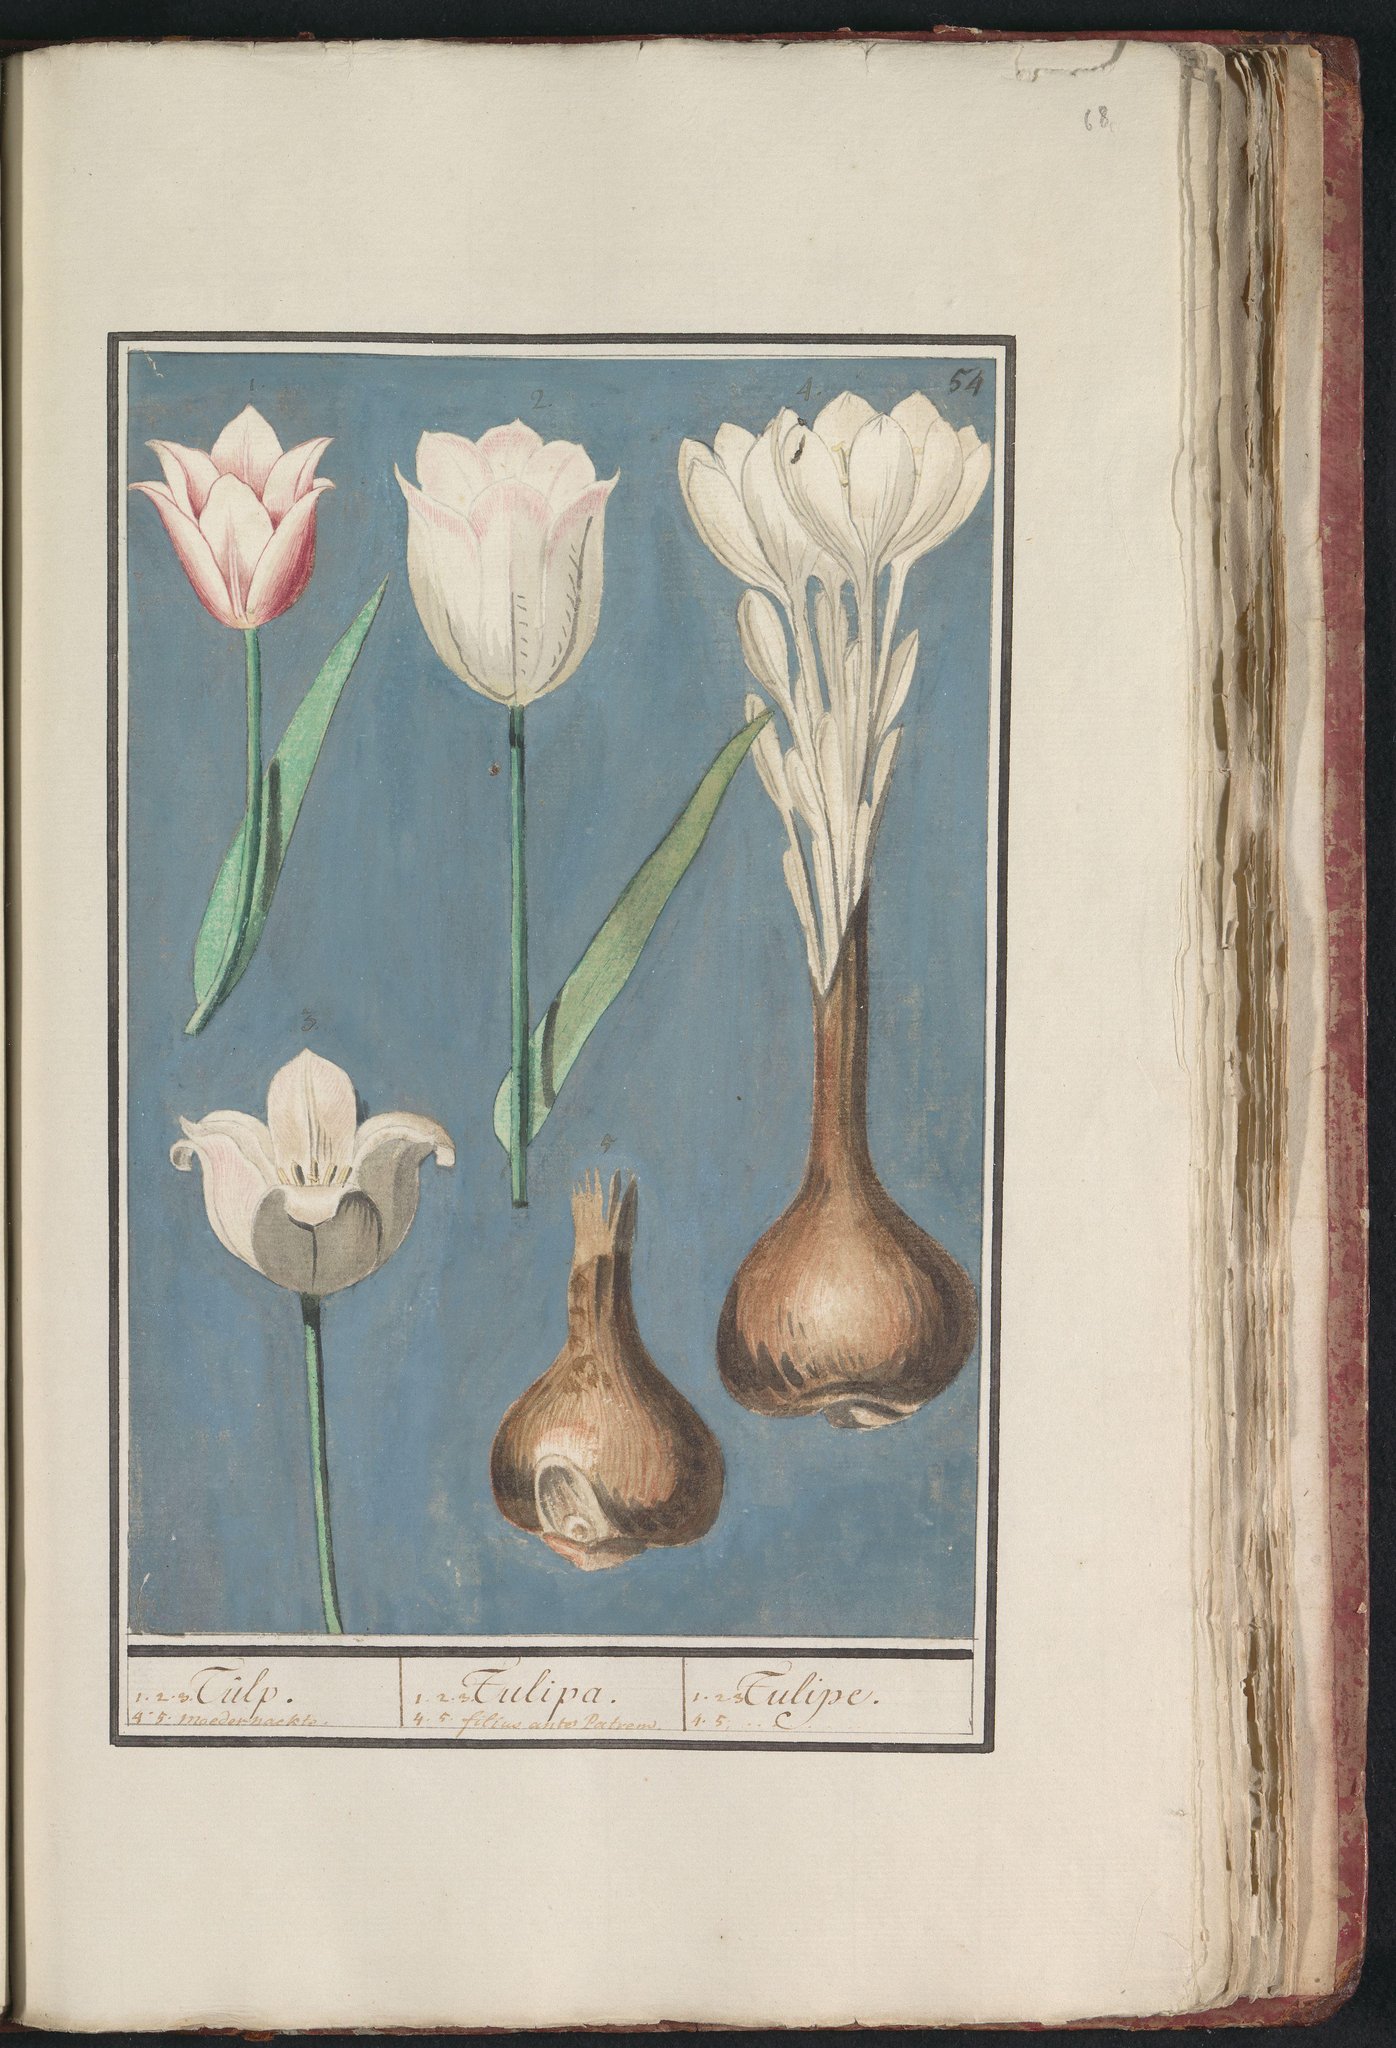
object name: drawing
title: Tulp. / Tulipa. / Tulipe.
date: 1596-1610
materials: chalk, paint, paper, watercolor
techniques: brush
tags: flowers: tulip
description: Vier witte tulpen en twee bollen tegen een blauw achtergrond. Genummerd rechtsboven: 54. Onderdeel van het eerste album met tekeningen van bloemen en planten. Achtste van twaalf albums met tekeningen van dieren, vogels en planten bekend rond 1600, gemaakt in opdracht van keizer Rudolf II. Met toelichting in Nederlands, Latijn en Frans.